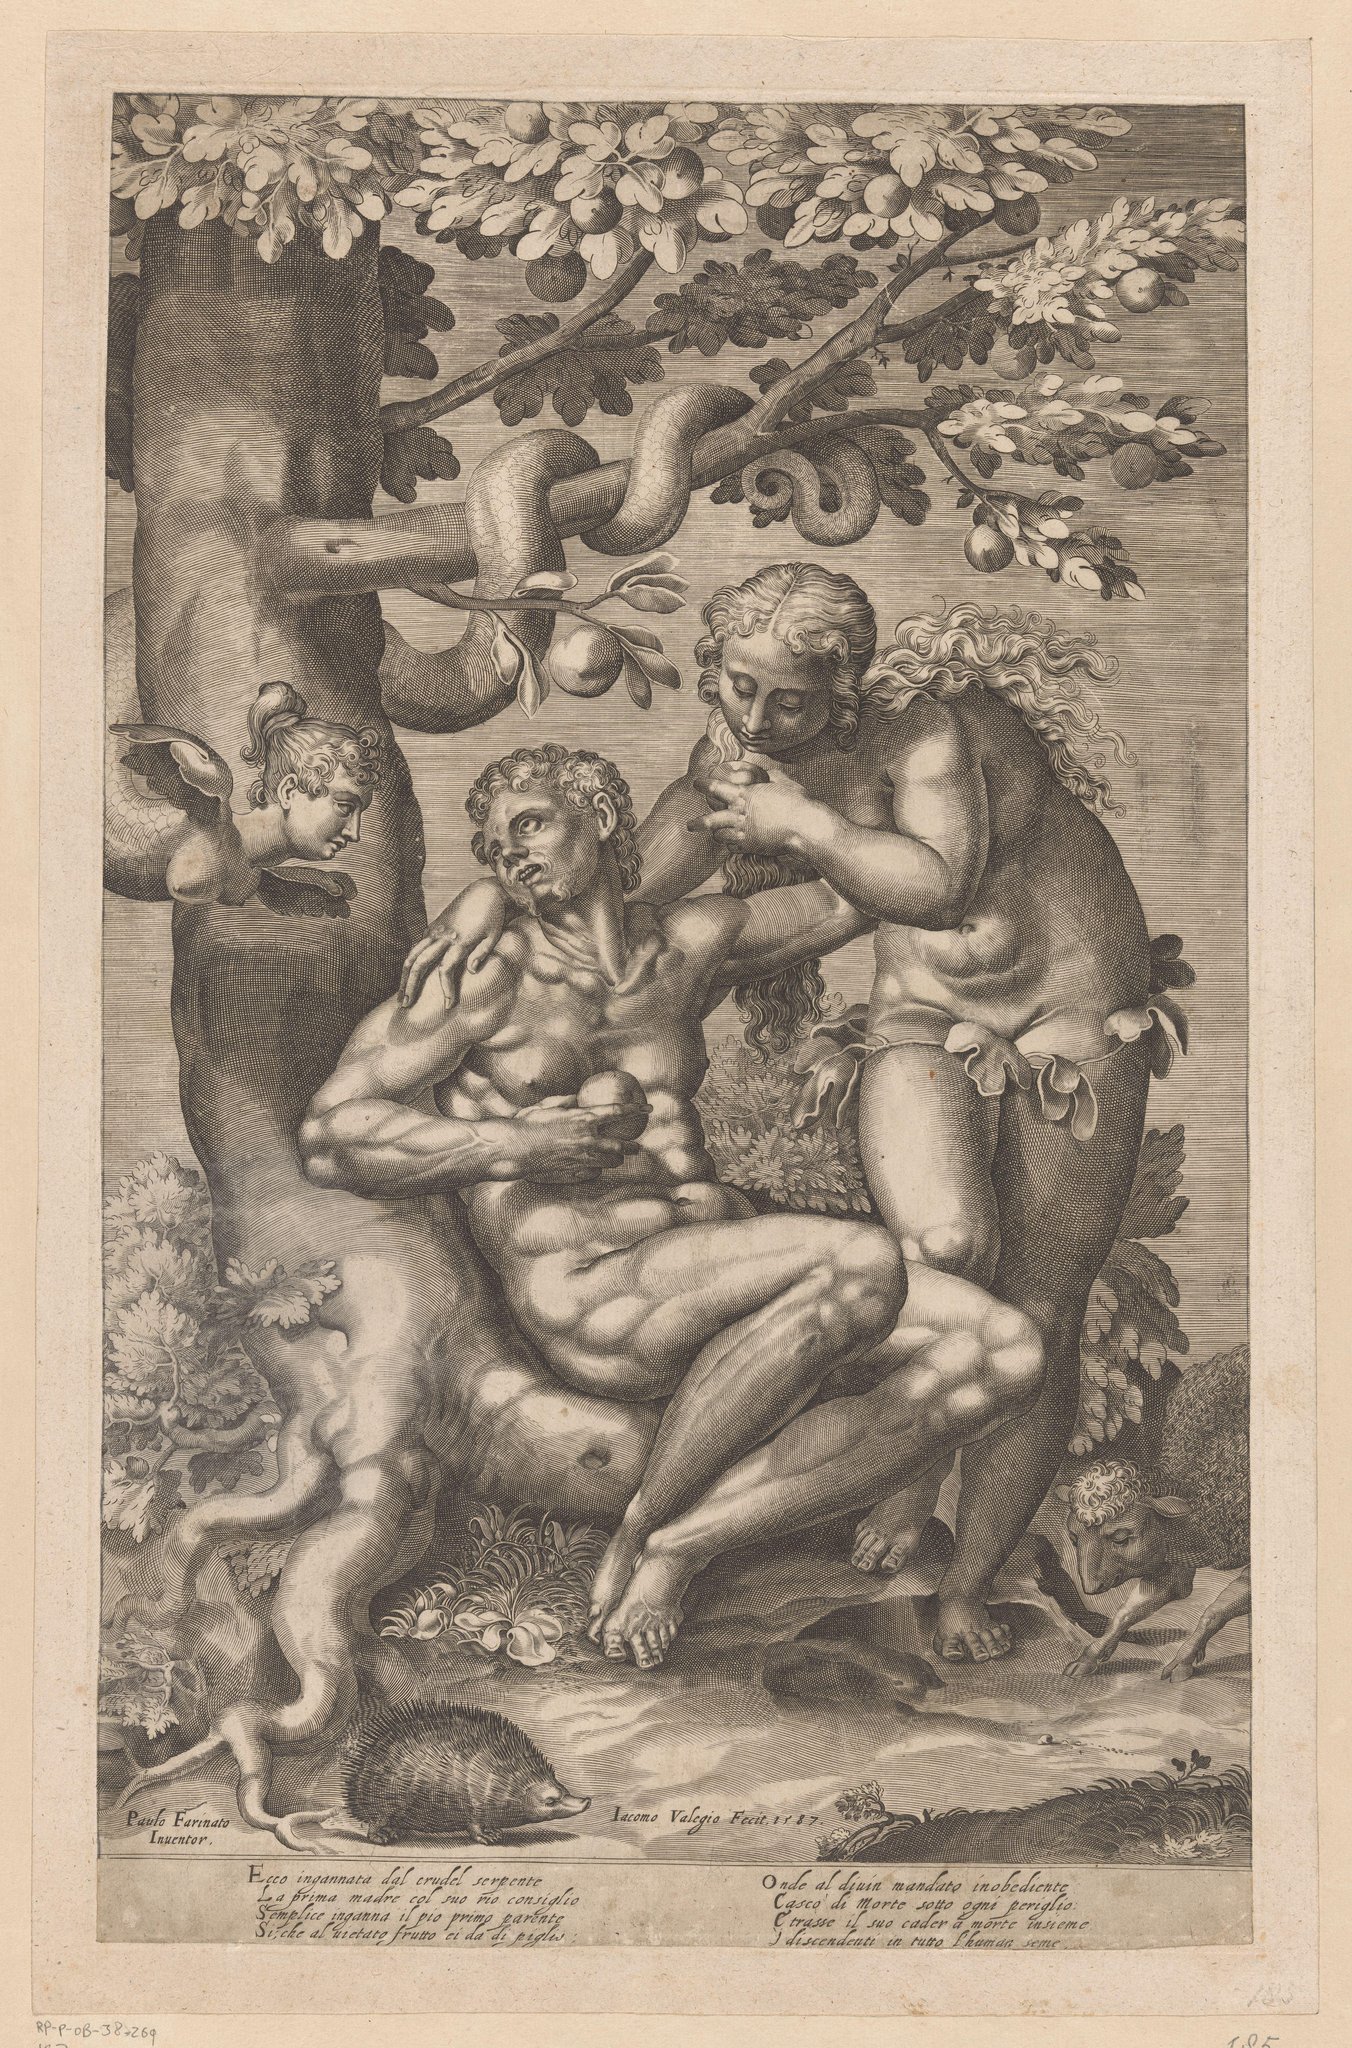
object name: print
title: Zondeval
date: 1587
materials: paper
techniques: engraving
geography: italy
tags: adam and eve holding (and possibly eating) the fruit, other mammals: hedgehog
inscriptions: collector's mark: Lugt 240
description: Adam en Eva bij de boom der kennis van goed en kwaad, beiden met een vrucht in de hand. Links de slang die zich rond de takken en stam van de boom kronkelt. Op de voorgrond een schaap en een egel. Italiaanse tekst in twee kolommen in ondermarge.